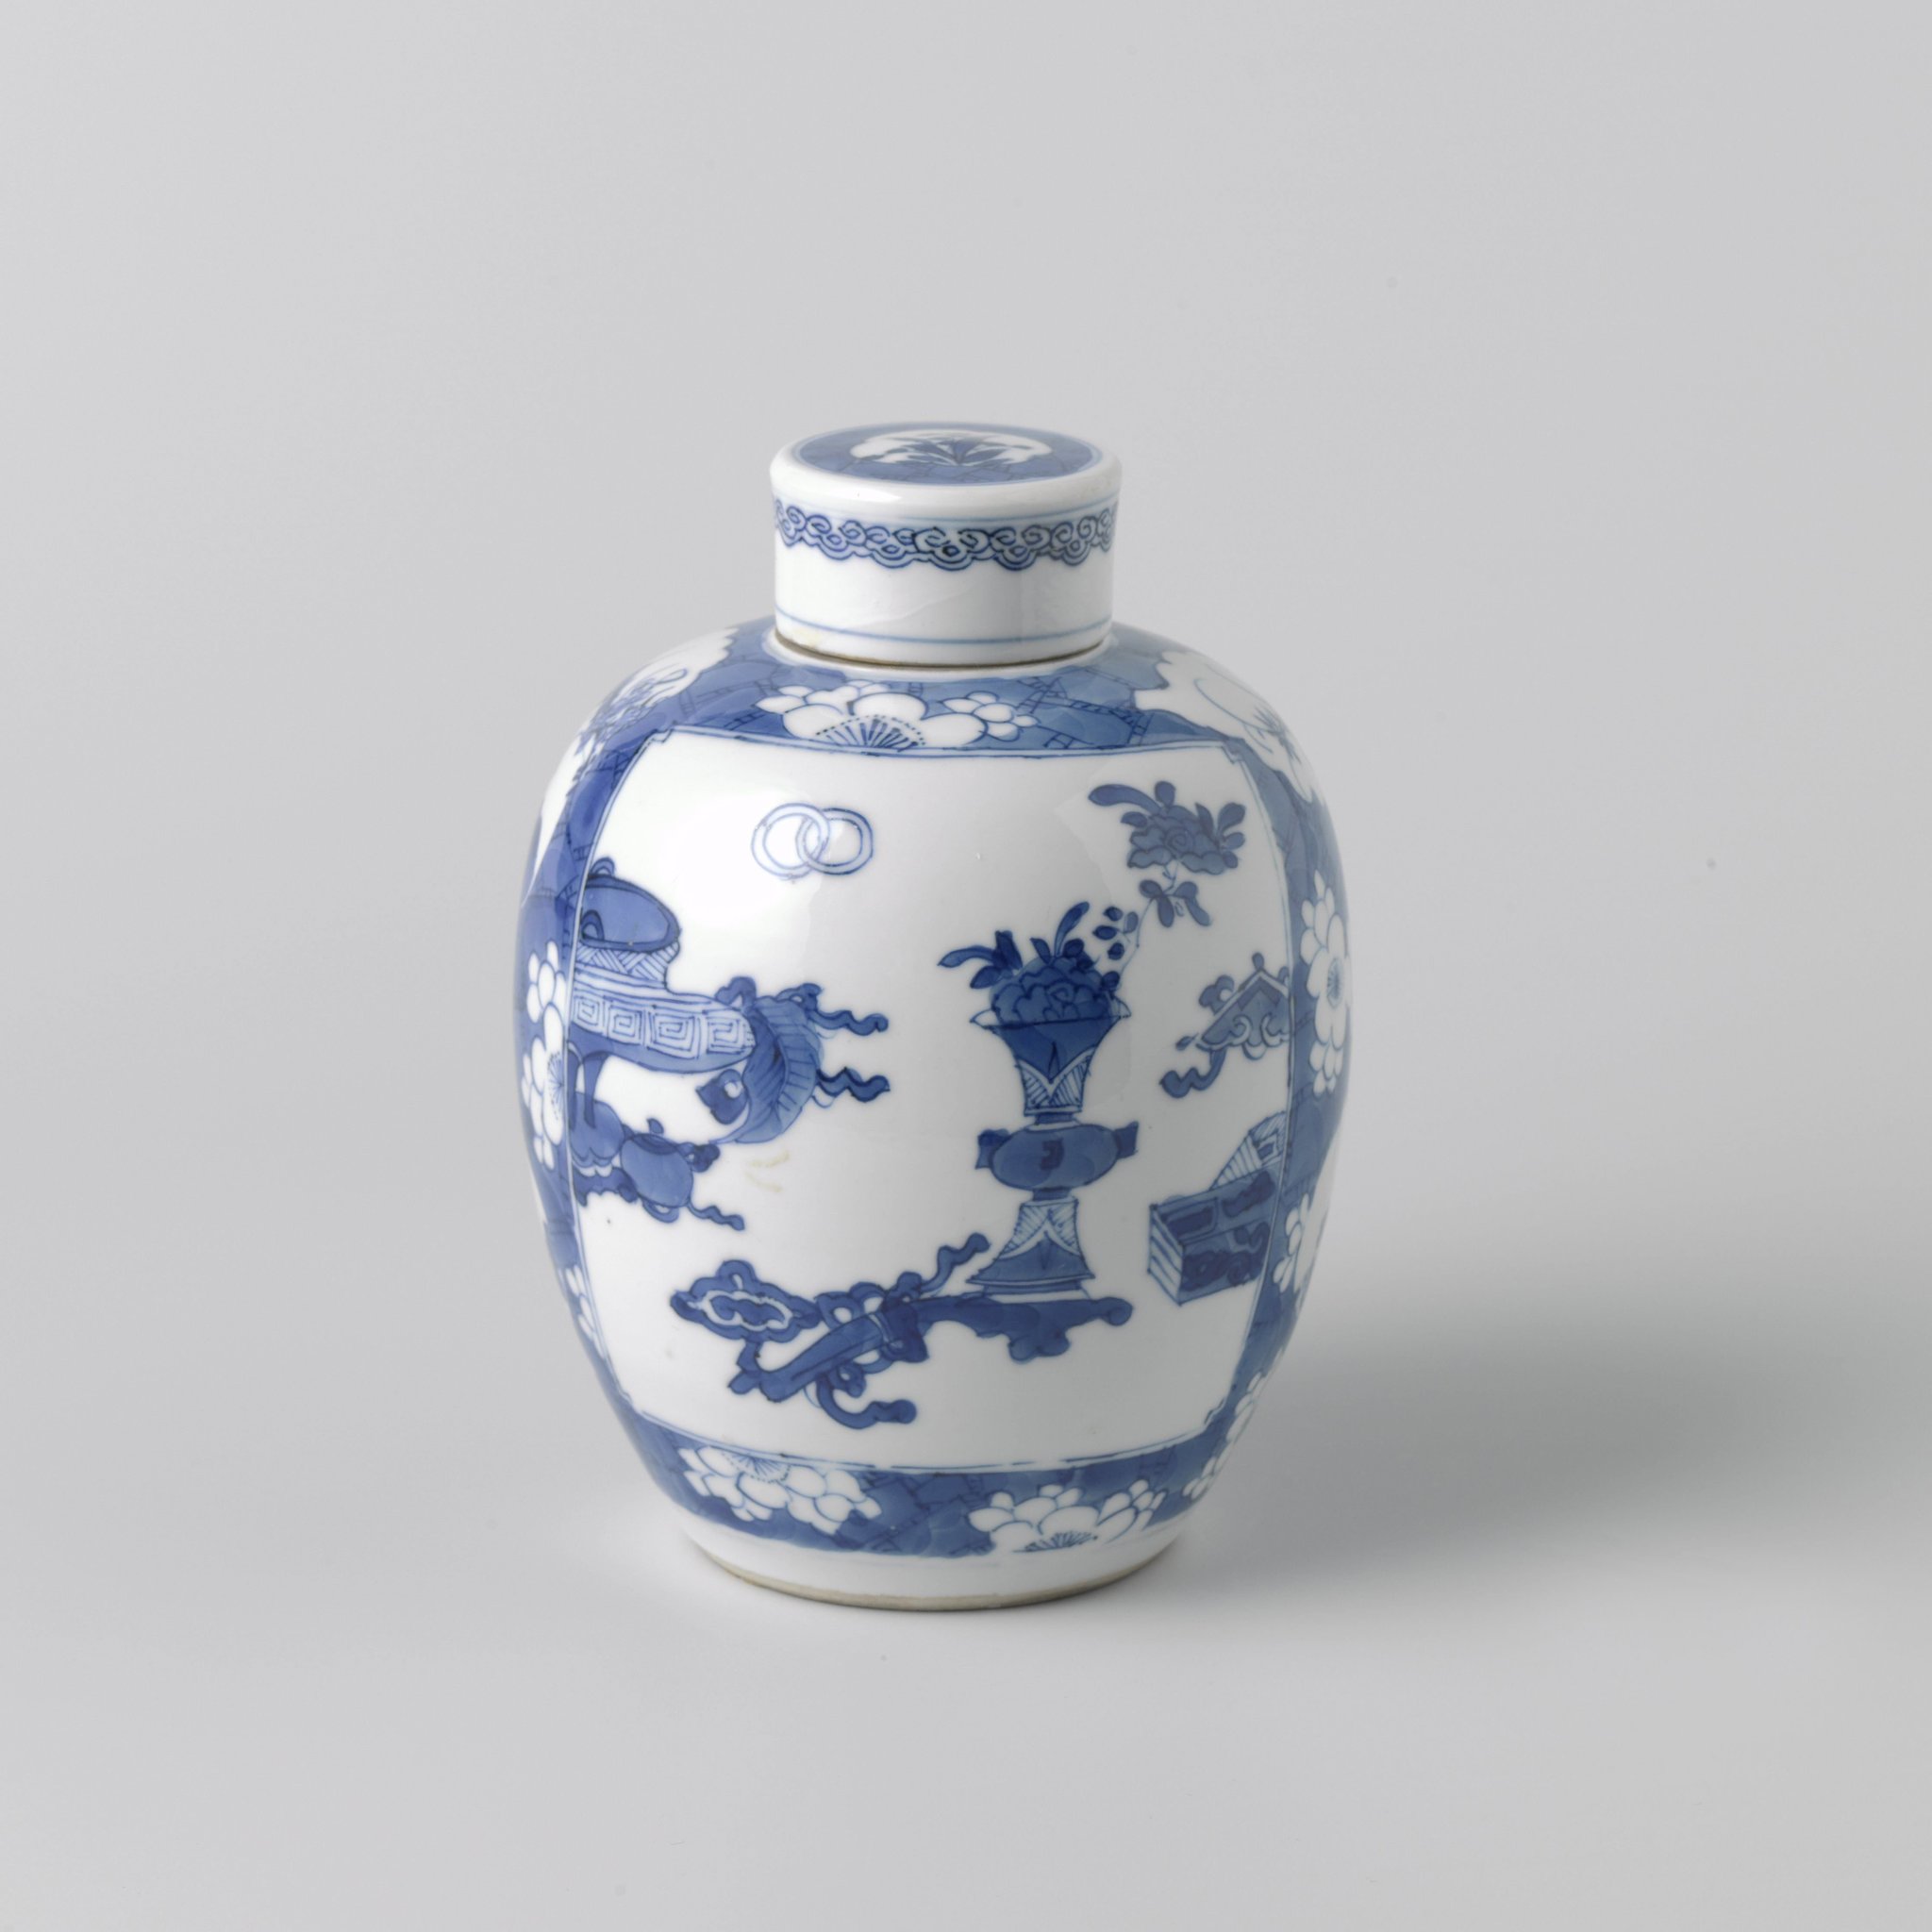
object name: covered jar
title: Ovoid covered jar with peachblossoms on 'crackled ice' and antiquities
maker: Anonymous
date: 1680-1720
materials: cobalt, glaze, paint, porcelain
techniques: firing, turning, vitrification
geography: china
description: Eivormige dekselpot van porselein, beschilderd in onderglazuur blauw. Het lichaam is bedekt met uitgespaarde perzikbloesems (prunus) tegen een achtergrond van 'crackled ice'. Hierop twee cartouches met kostbaarheden (artemisiablad, munt, parel) en antiquiteiten (bloemenvaas, wierookbrander, ruyi-scepter, driepoot, verpakte qin, lotusrank). De deksel met een uitgespaard, gelobd cartouche met een bloeiende plant tegen een achtergrond van 'crackled ice'. De rand met een band afhangende ruyi-motieven. Een barst in de deksel. Blauw-wit.